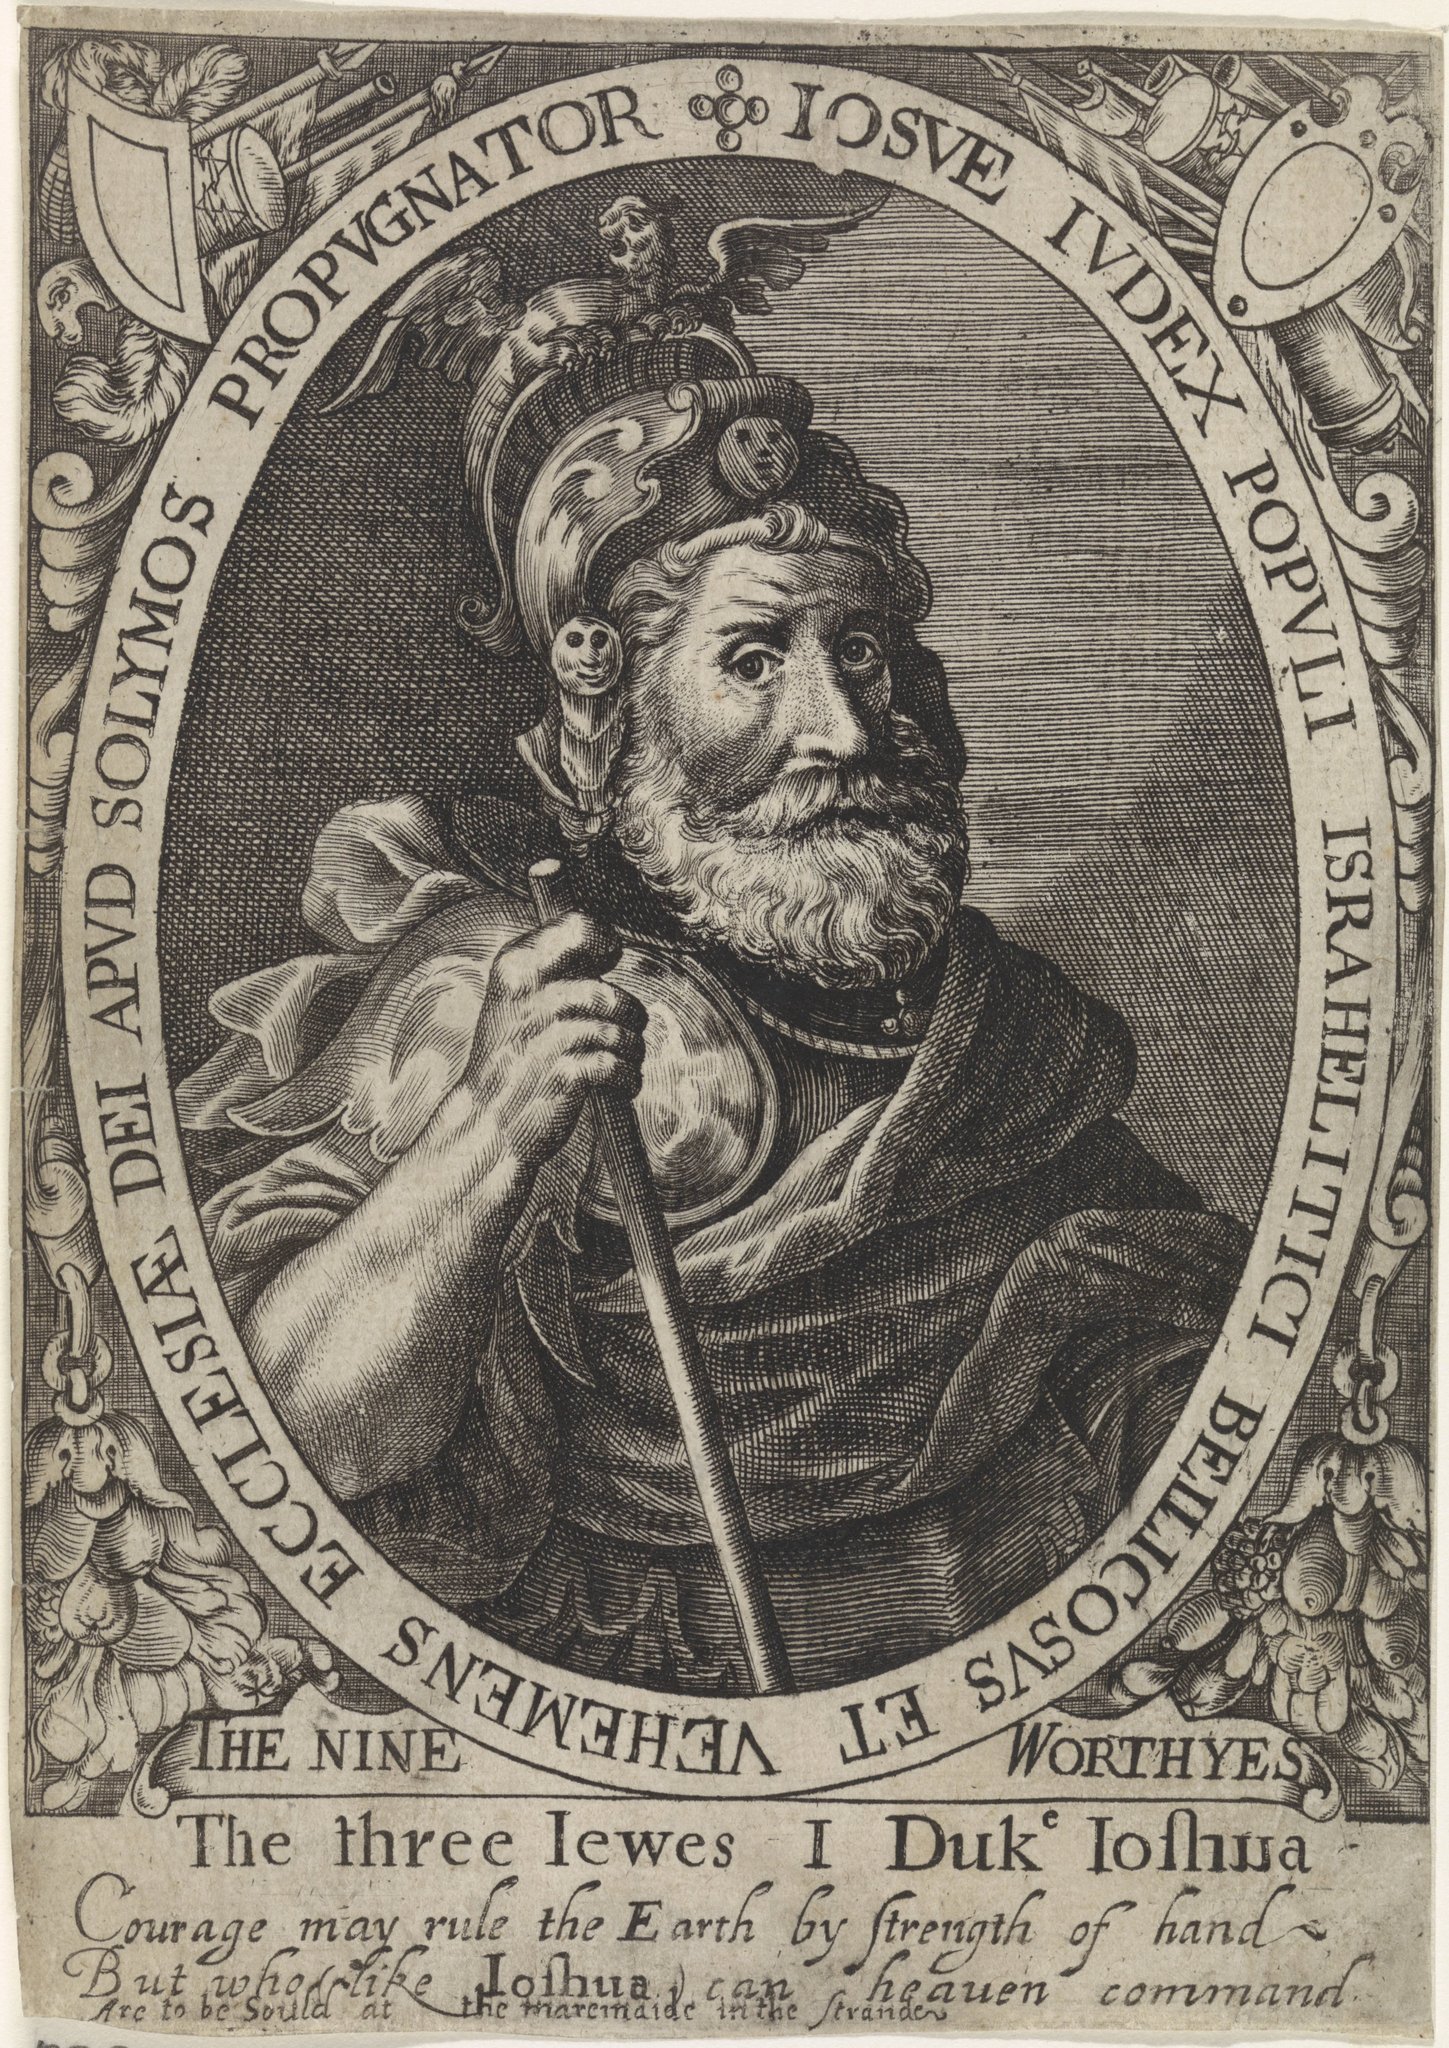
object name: print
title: Koning Jozua als een van de negen helden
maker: willem van de passe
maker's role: print maker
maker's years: 1597-1637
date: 1621-1636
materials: paper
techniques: engraving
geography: london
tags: joshua (one of the nine worthies)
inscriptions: collector's mark: Lugt 2228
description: De Joodse held koning Jozua. Buste gevat in een ovale omlijsting met een randschrift in het Latijn. In de marge zijn naam en een drieregelig lofdicht in het Engels.